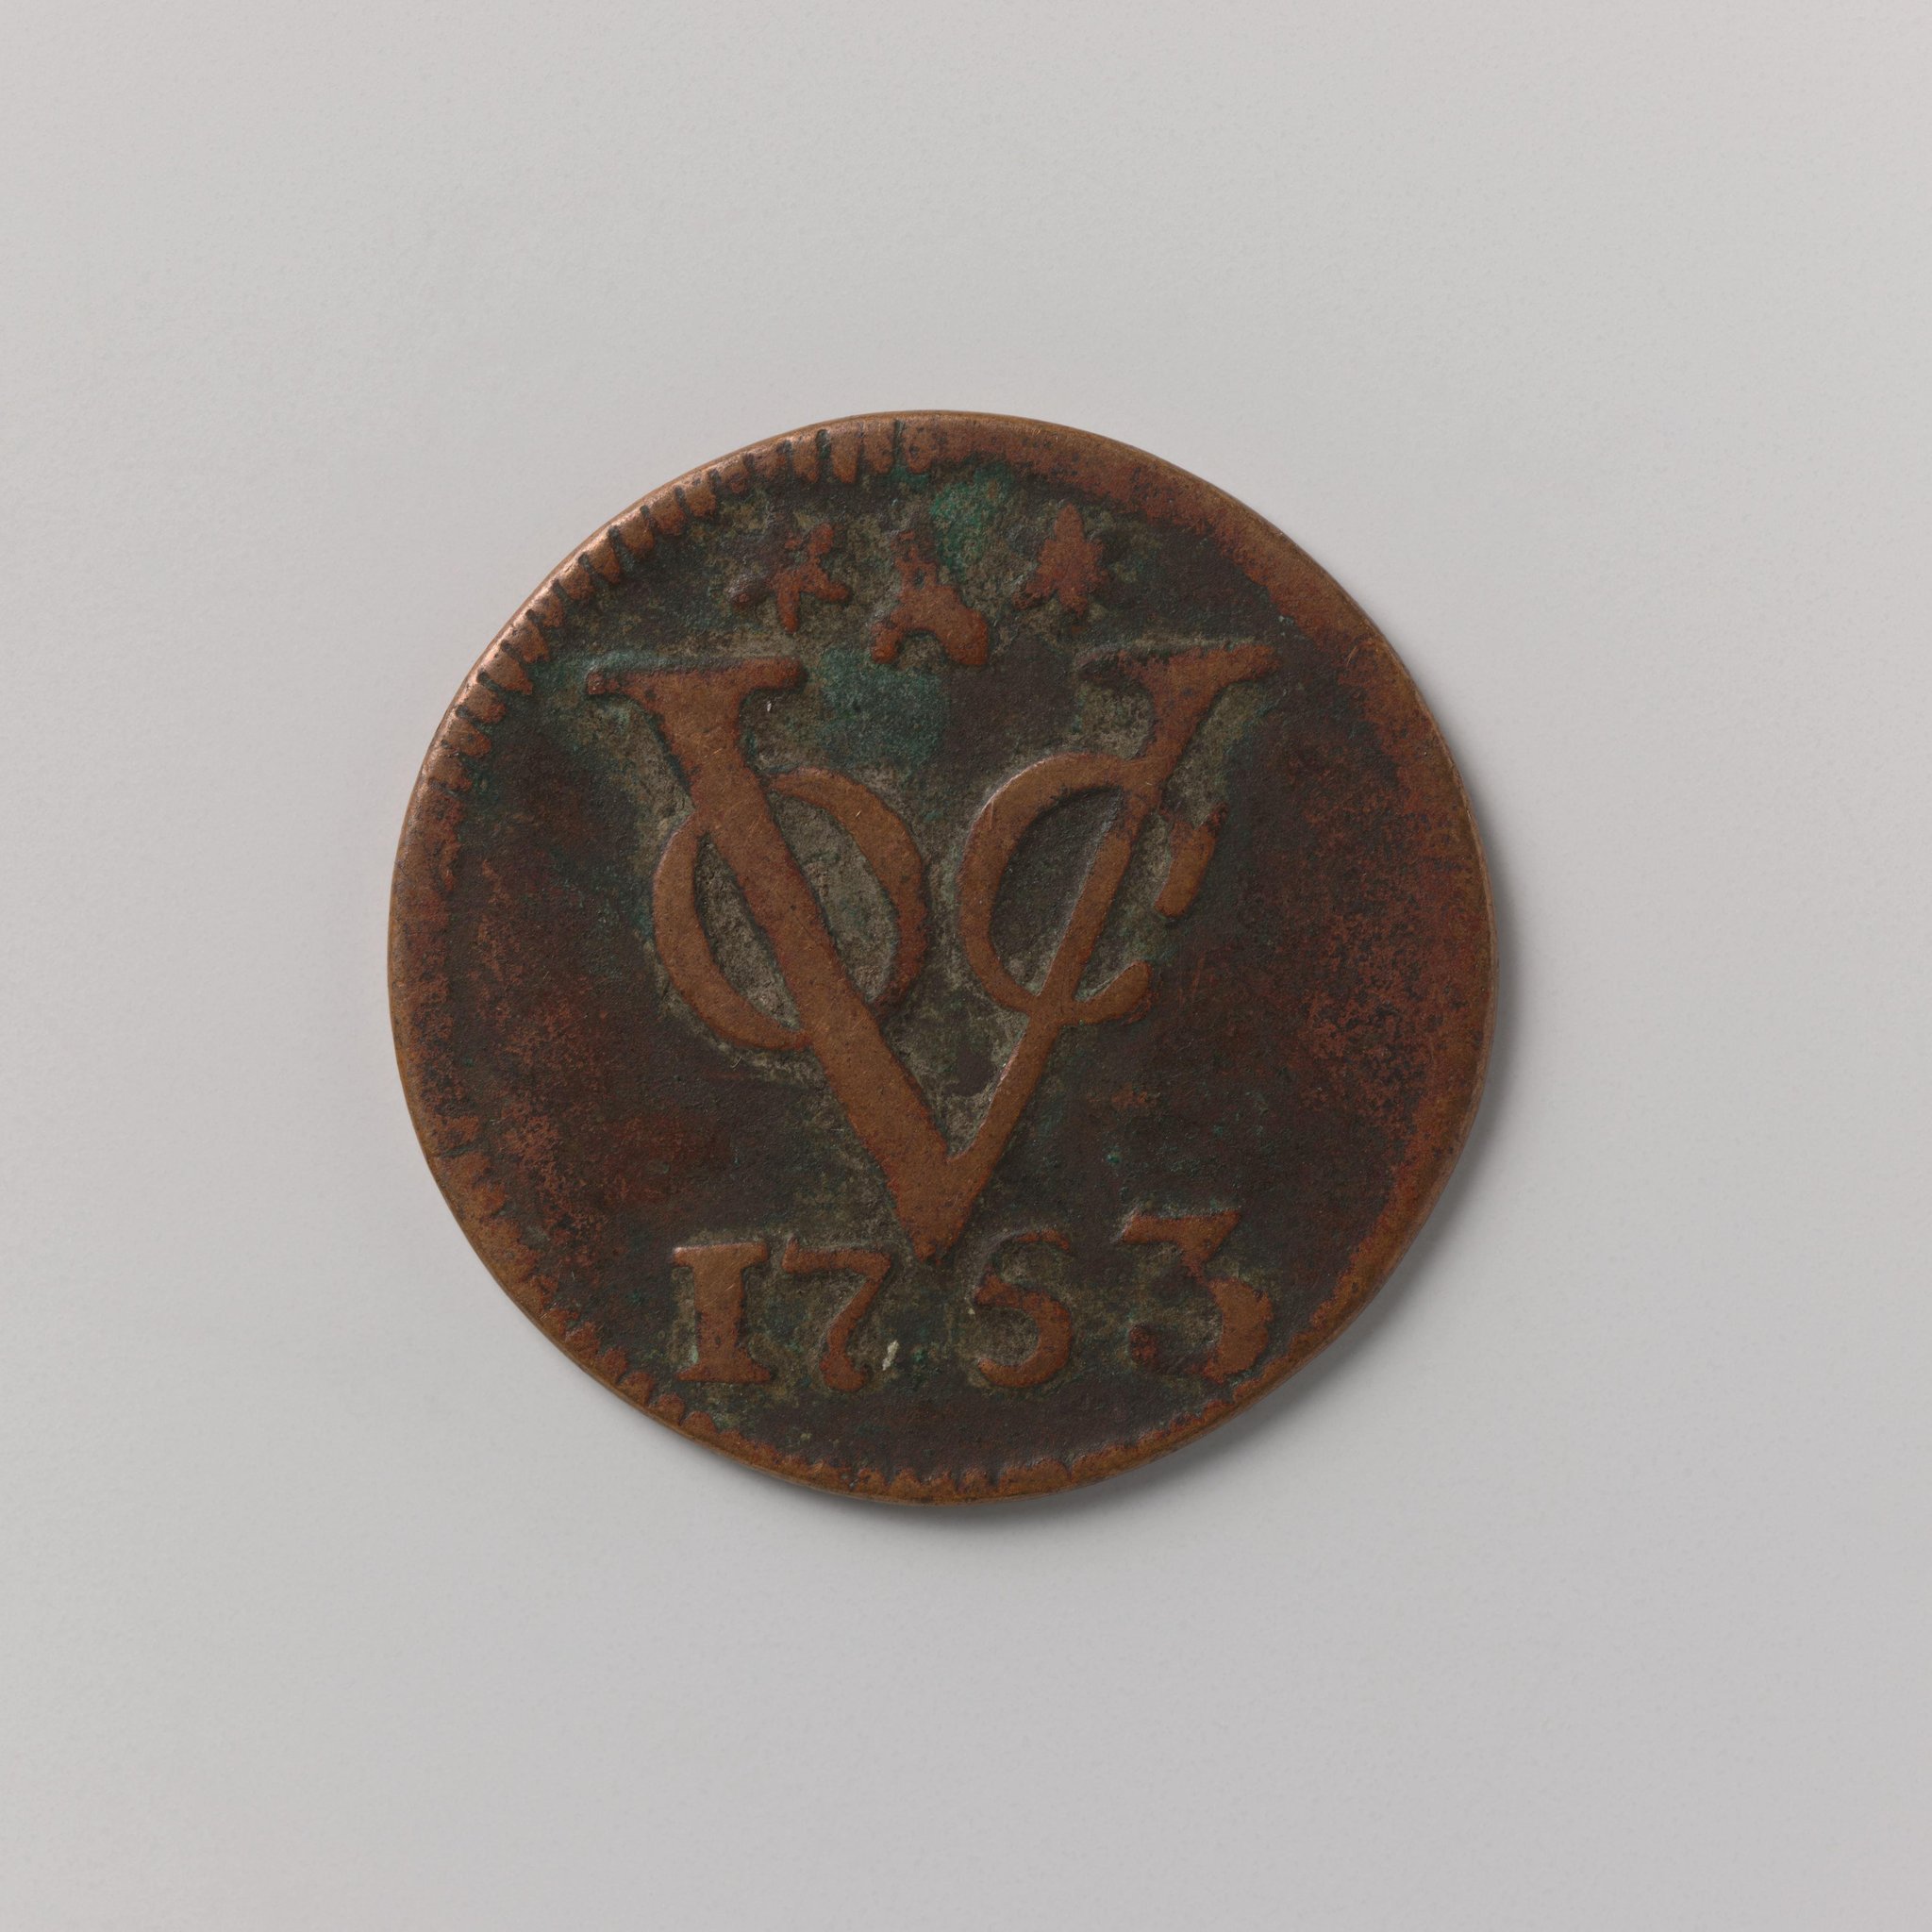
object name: coin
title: Duit van de VOC uit Zeeland, 1753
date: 1753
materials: copper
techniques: striking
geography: middelburg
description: Koperen munt. Voorzijde: gekroond wapenschild van Zeeland. Keerzijde: monogram van de VOC, waarboven muntteken en waaronder jaartal. Gladde rand.